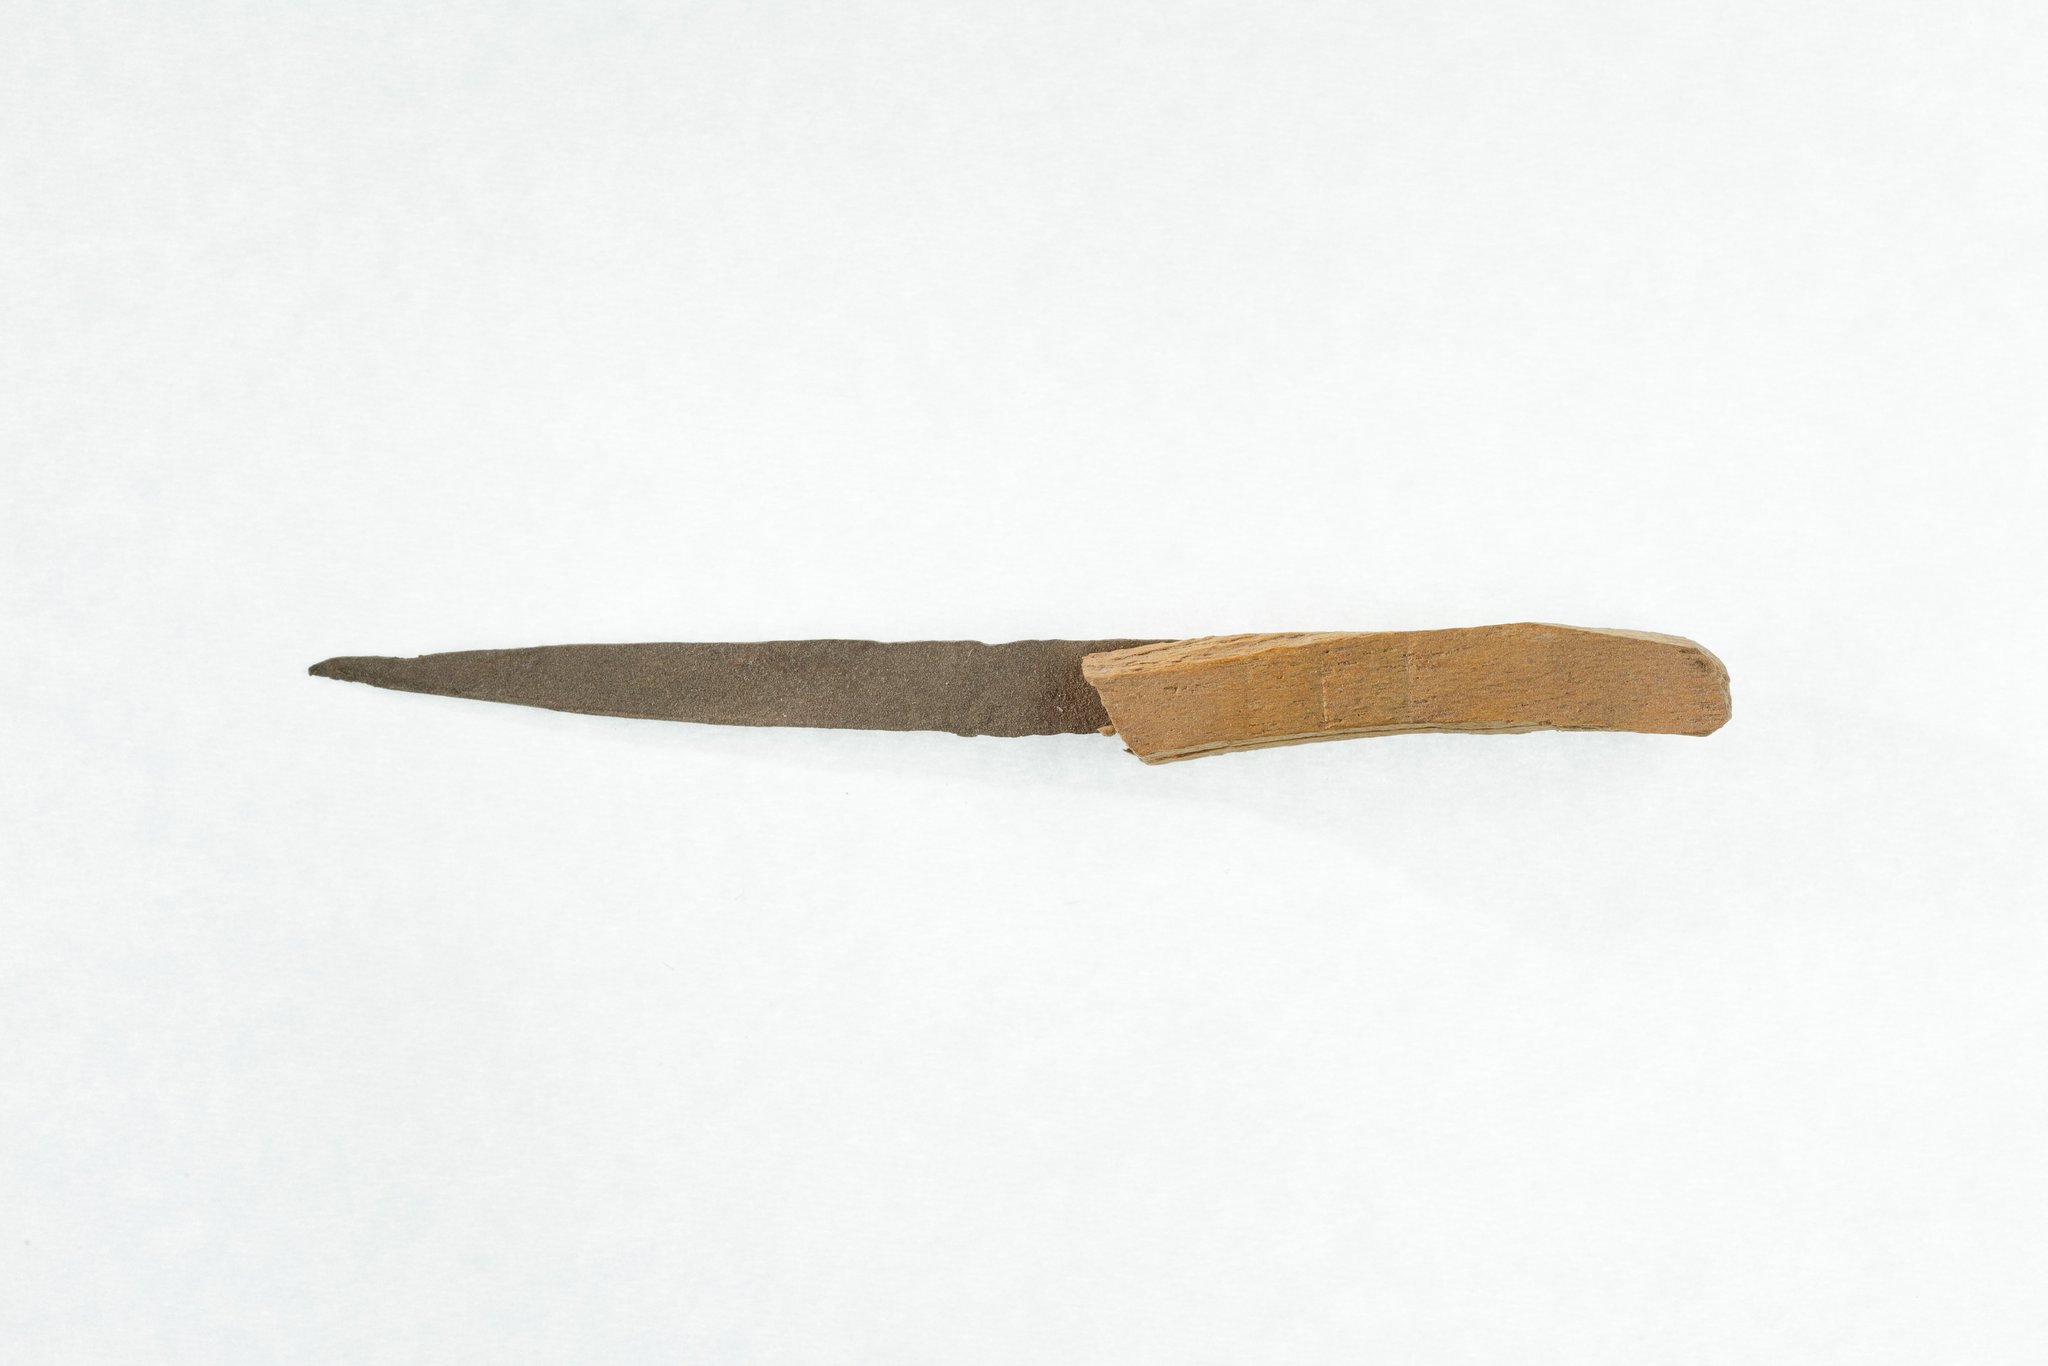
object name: saw, model, tool, senenmut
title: Model Saw from a Foundation Deposit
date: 1479-1458 BCE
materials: bronze, copper alloy, wood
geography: egypt